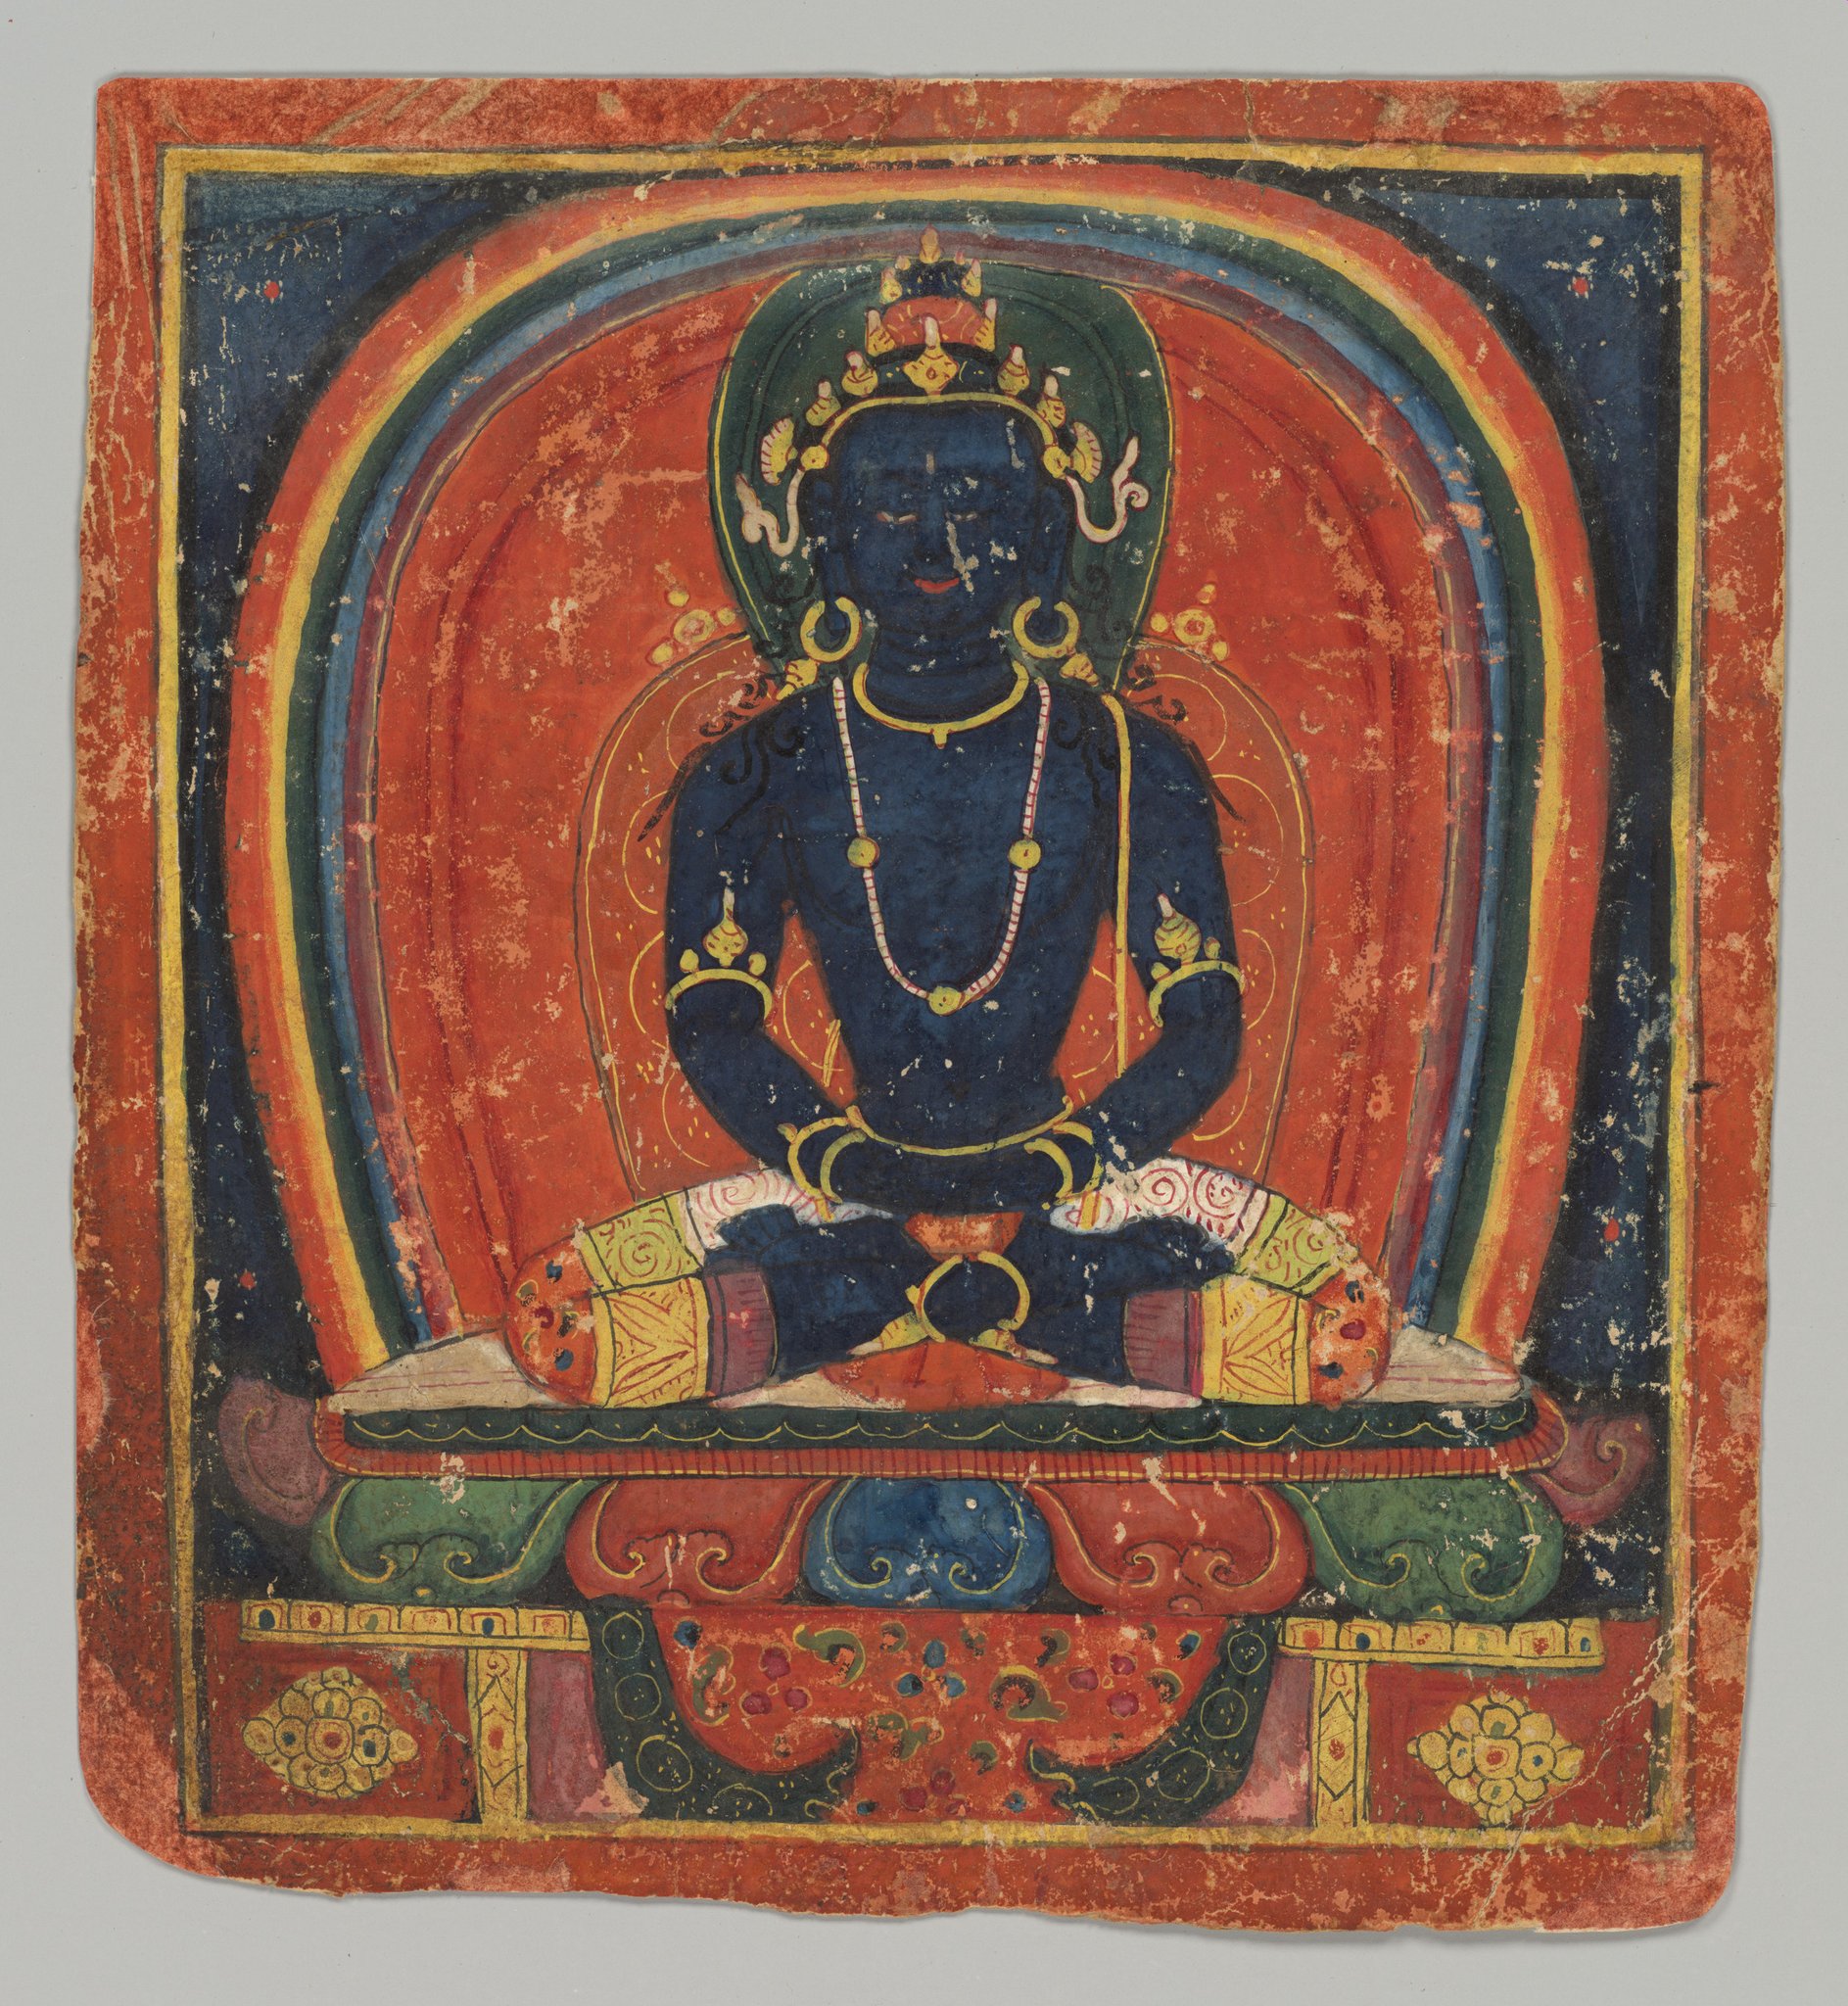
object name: initiation card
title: Initiation Card (Tsakalis): Samanthabhandra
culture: tibetan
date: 1401-1433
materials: paper, watercolor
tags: buddhism